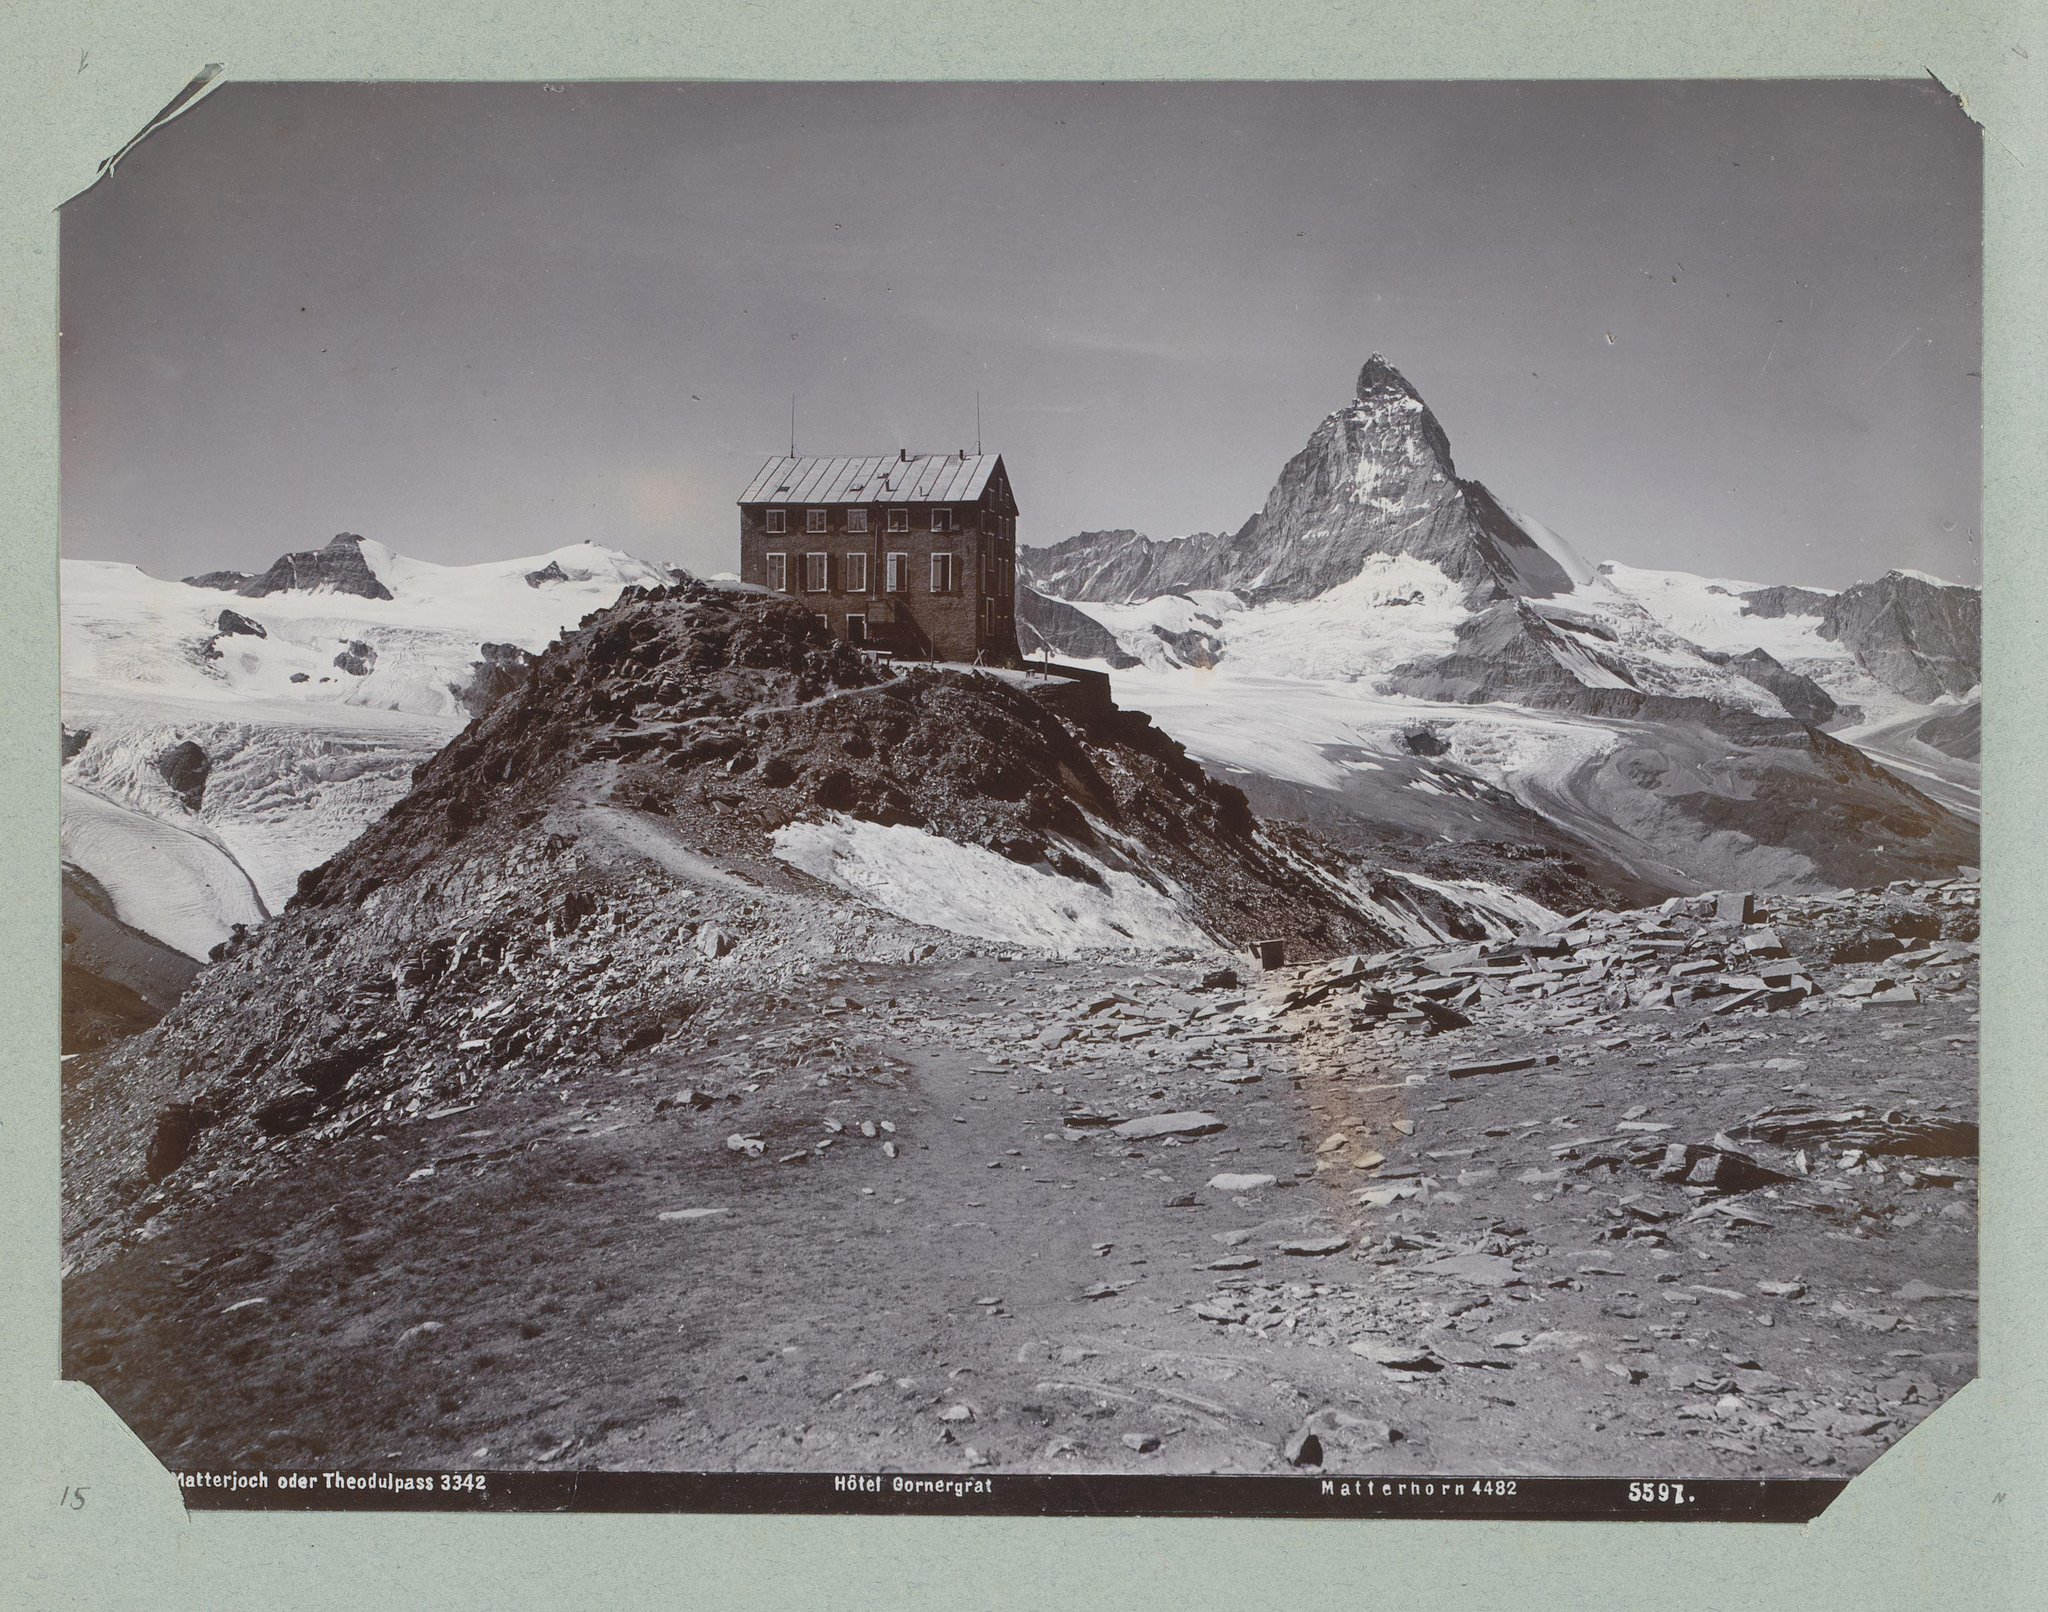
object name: album leaf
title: Gezicht op de Matterhorn en Hotel Gornergrat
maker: Anonymous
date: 1897-1900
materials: paper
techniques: collodion silver print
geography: kilchberg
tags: hotel, hostelry, inn, mountains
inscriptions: inscription: ‘Matterjoch oder Theodulpass 3342 Hôtel Gornergrat Matterhorn 4482 5597.’